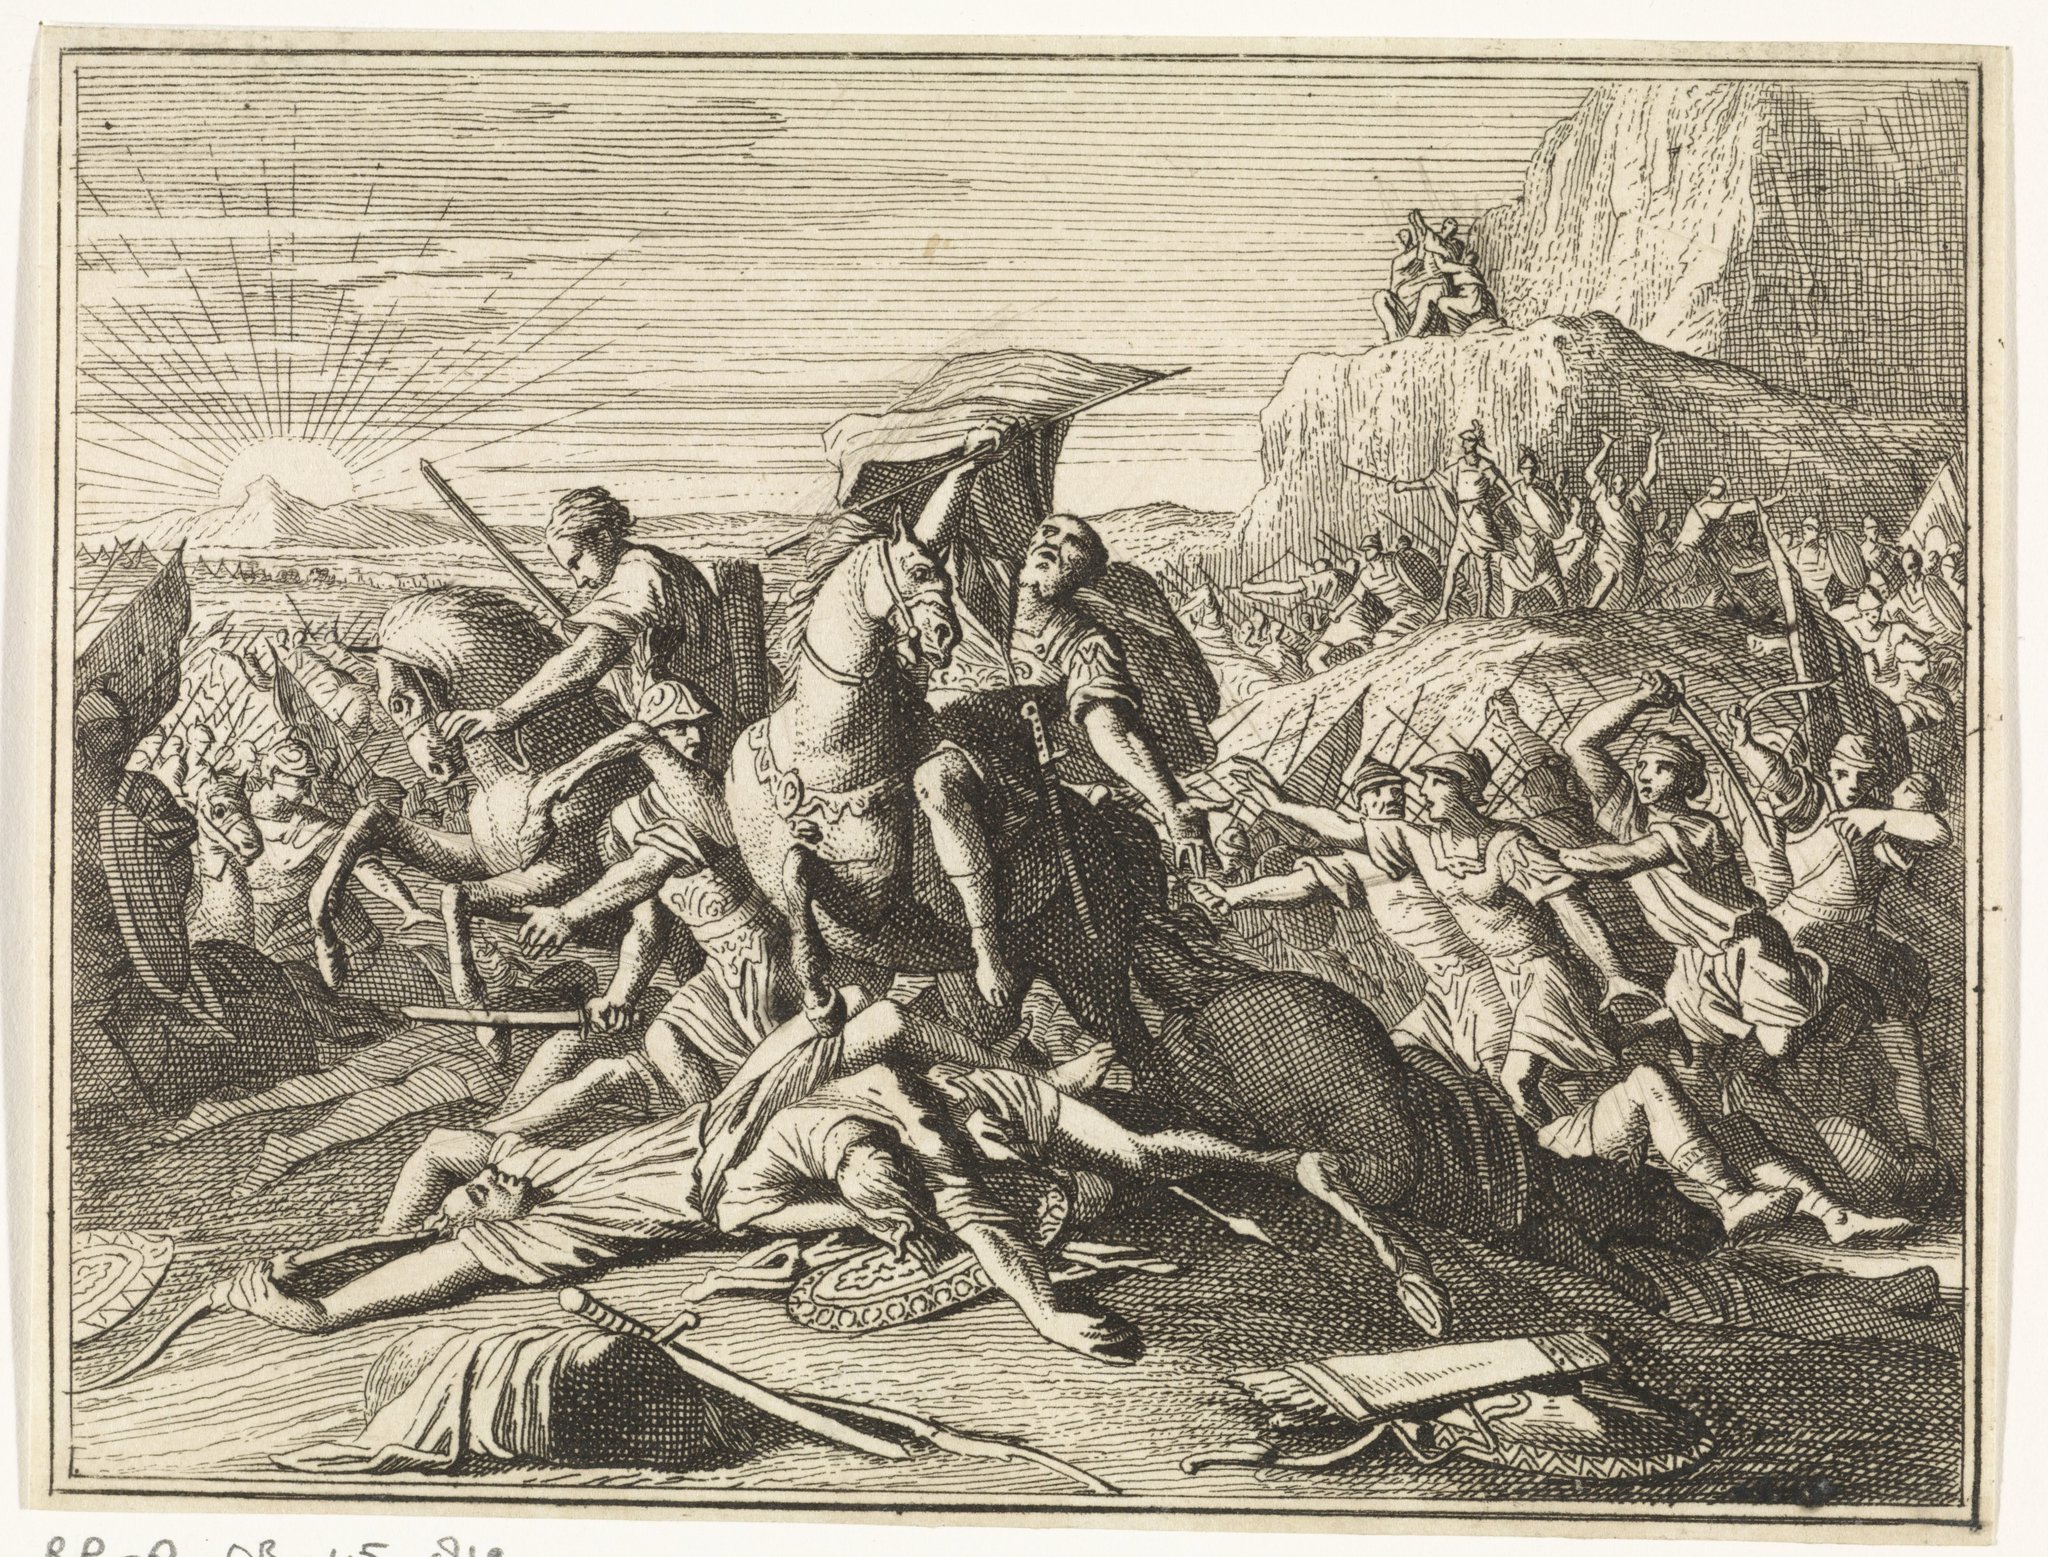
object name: print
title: Slag van Israël tegen de Amalekieten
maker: caspar luyken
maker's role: draughtsman, print maker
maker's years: 1672-1708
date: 1712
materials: paper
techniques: etching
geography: amsterdam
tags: the amalekites come to war against the israelites (exodus 17:8-16)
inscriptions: collector's mark: Lugt 2228, number: ‘65’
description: Illustratie uit: Luyken, Jan. De schriftuurlyke geschiedenissen en gelykenissen van het Oude en Nieuwe Verbond, 2 delen. Amsterdam: Wed. Pieter Arentsz II en Cornelis van der Sys, 1712, dl. I.